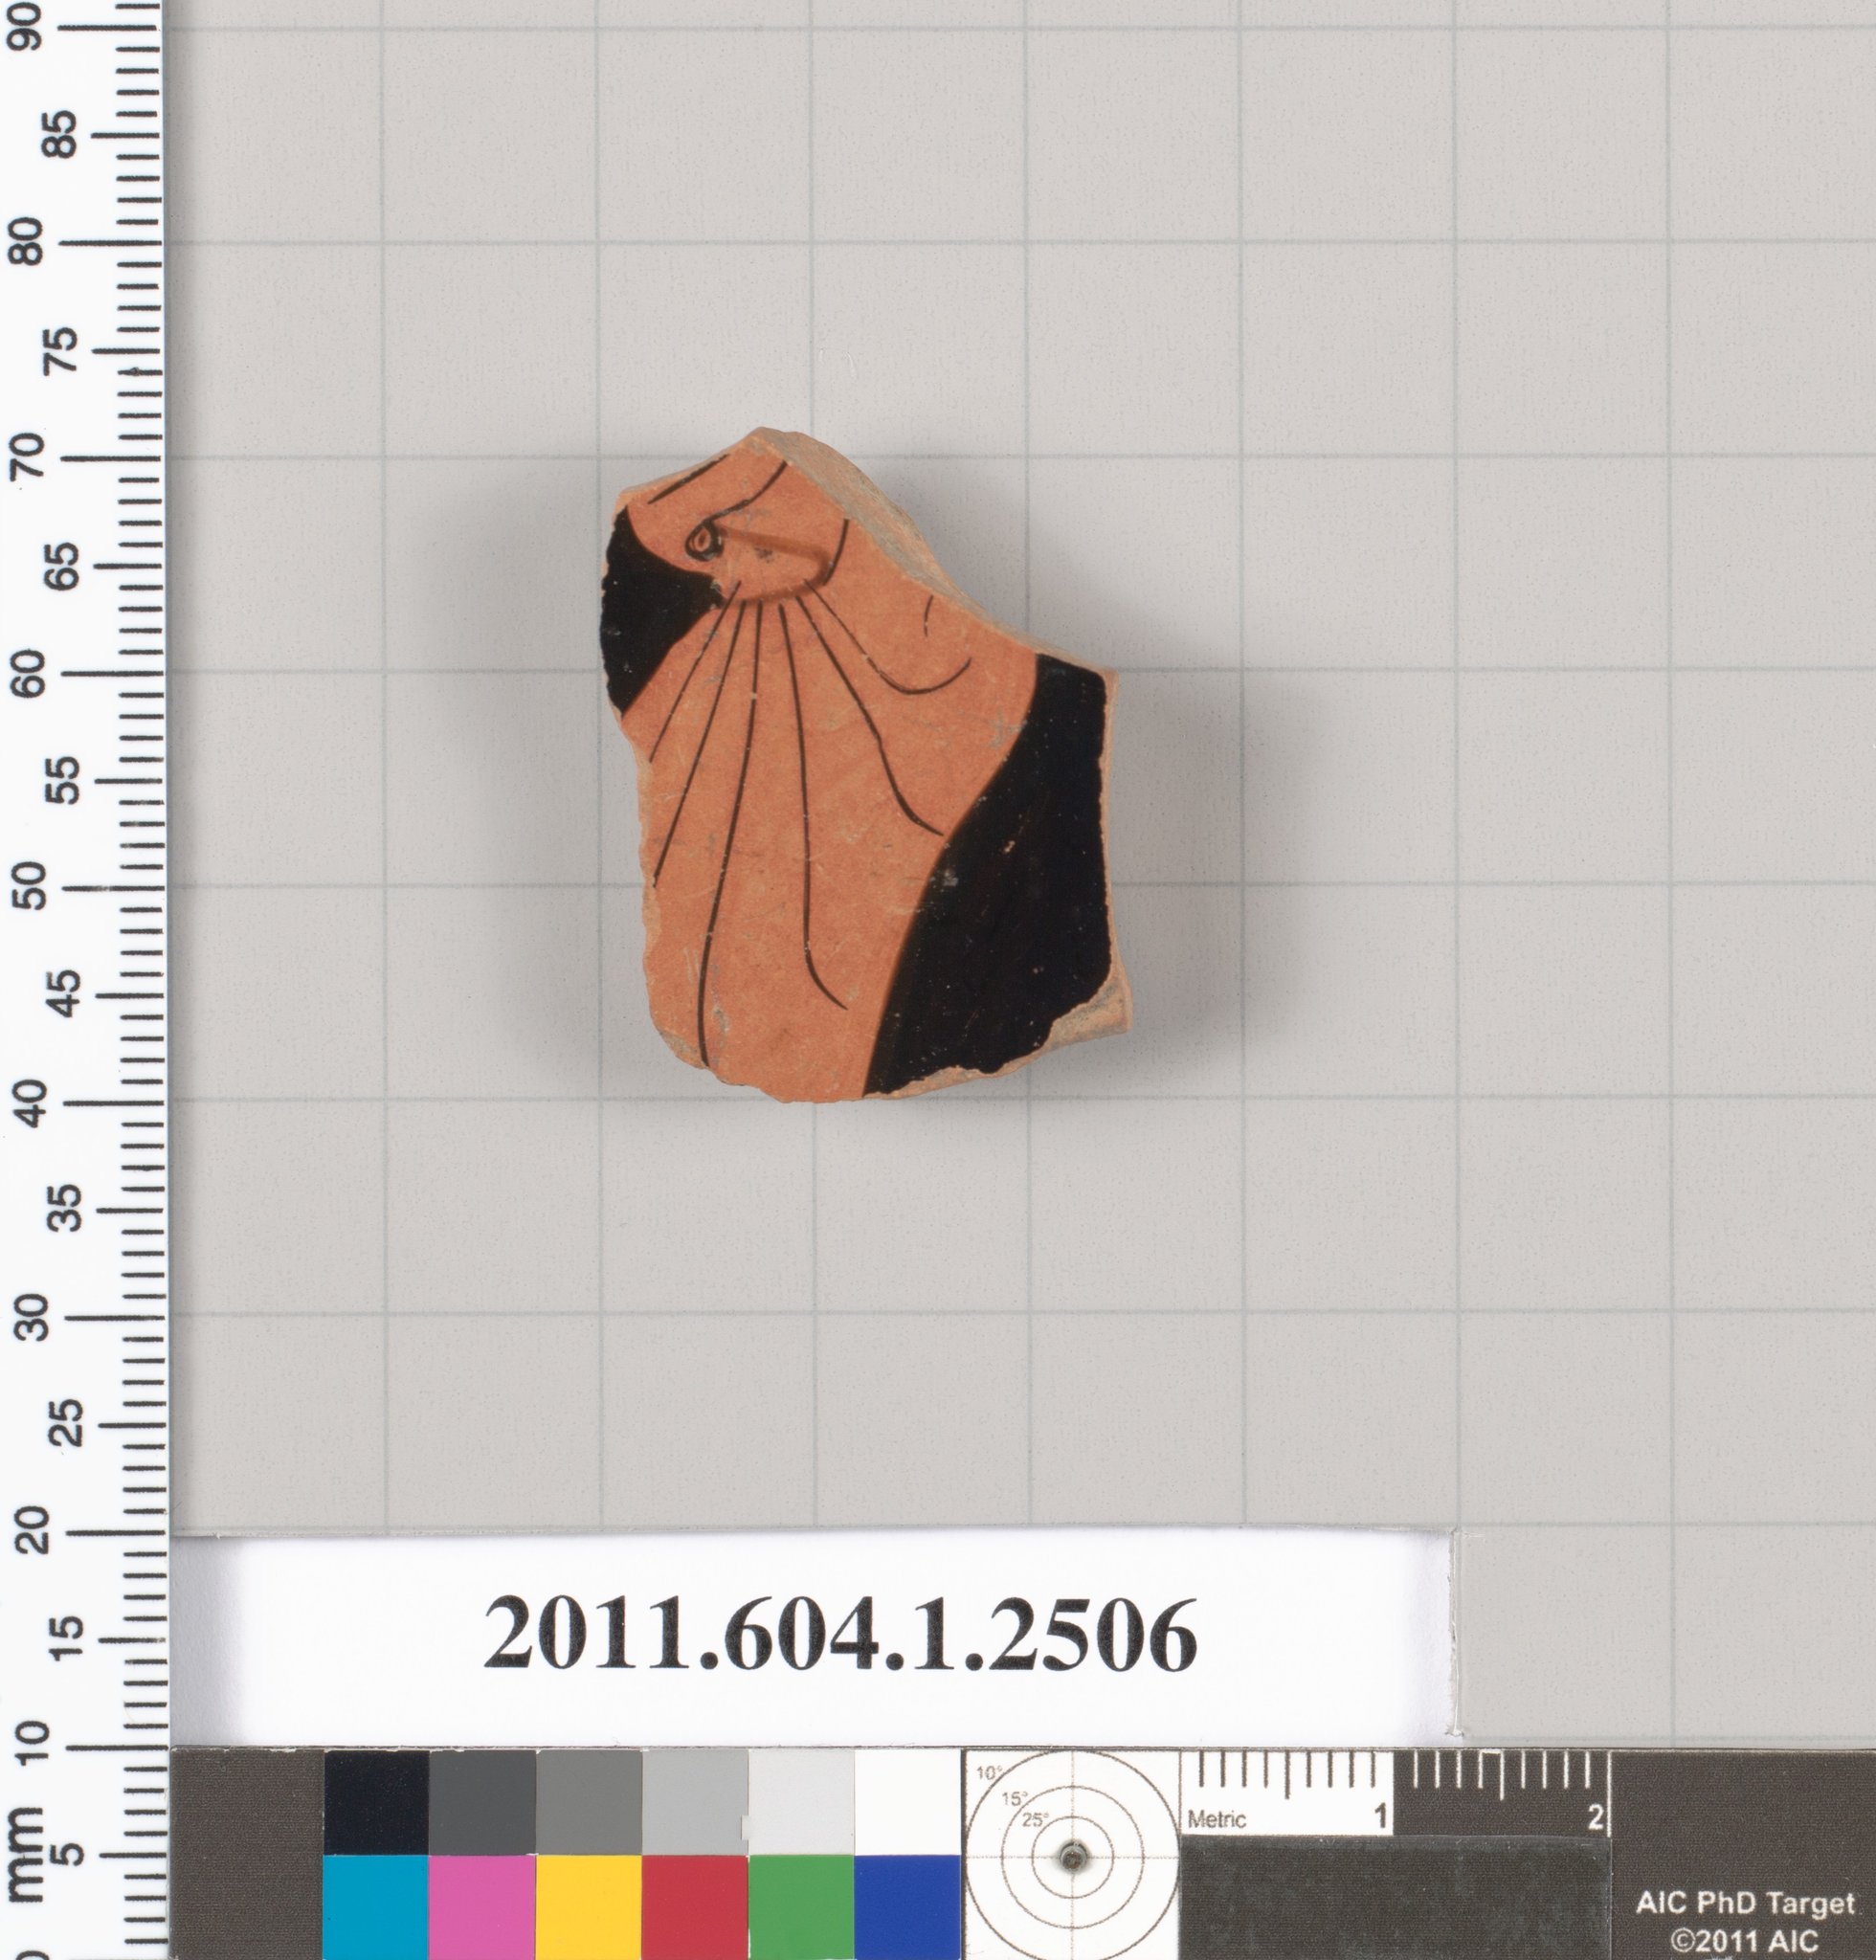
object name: kylix fragment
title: Terracotta fragment of a kylix (drinking cup)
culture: greek, attic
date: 475-451 BCE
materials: terracotta